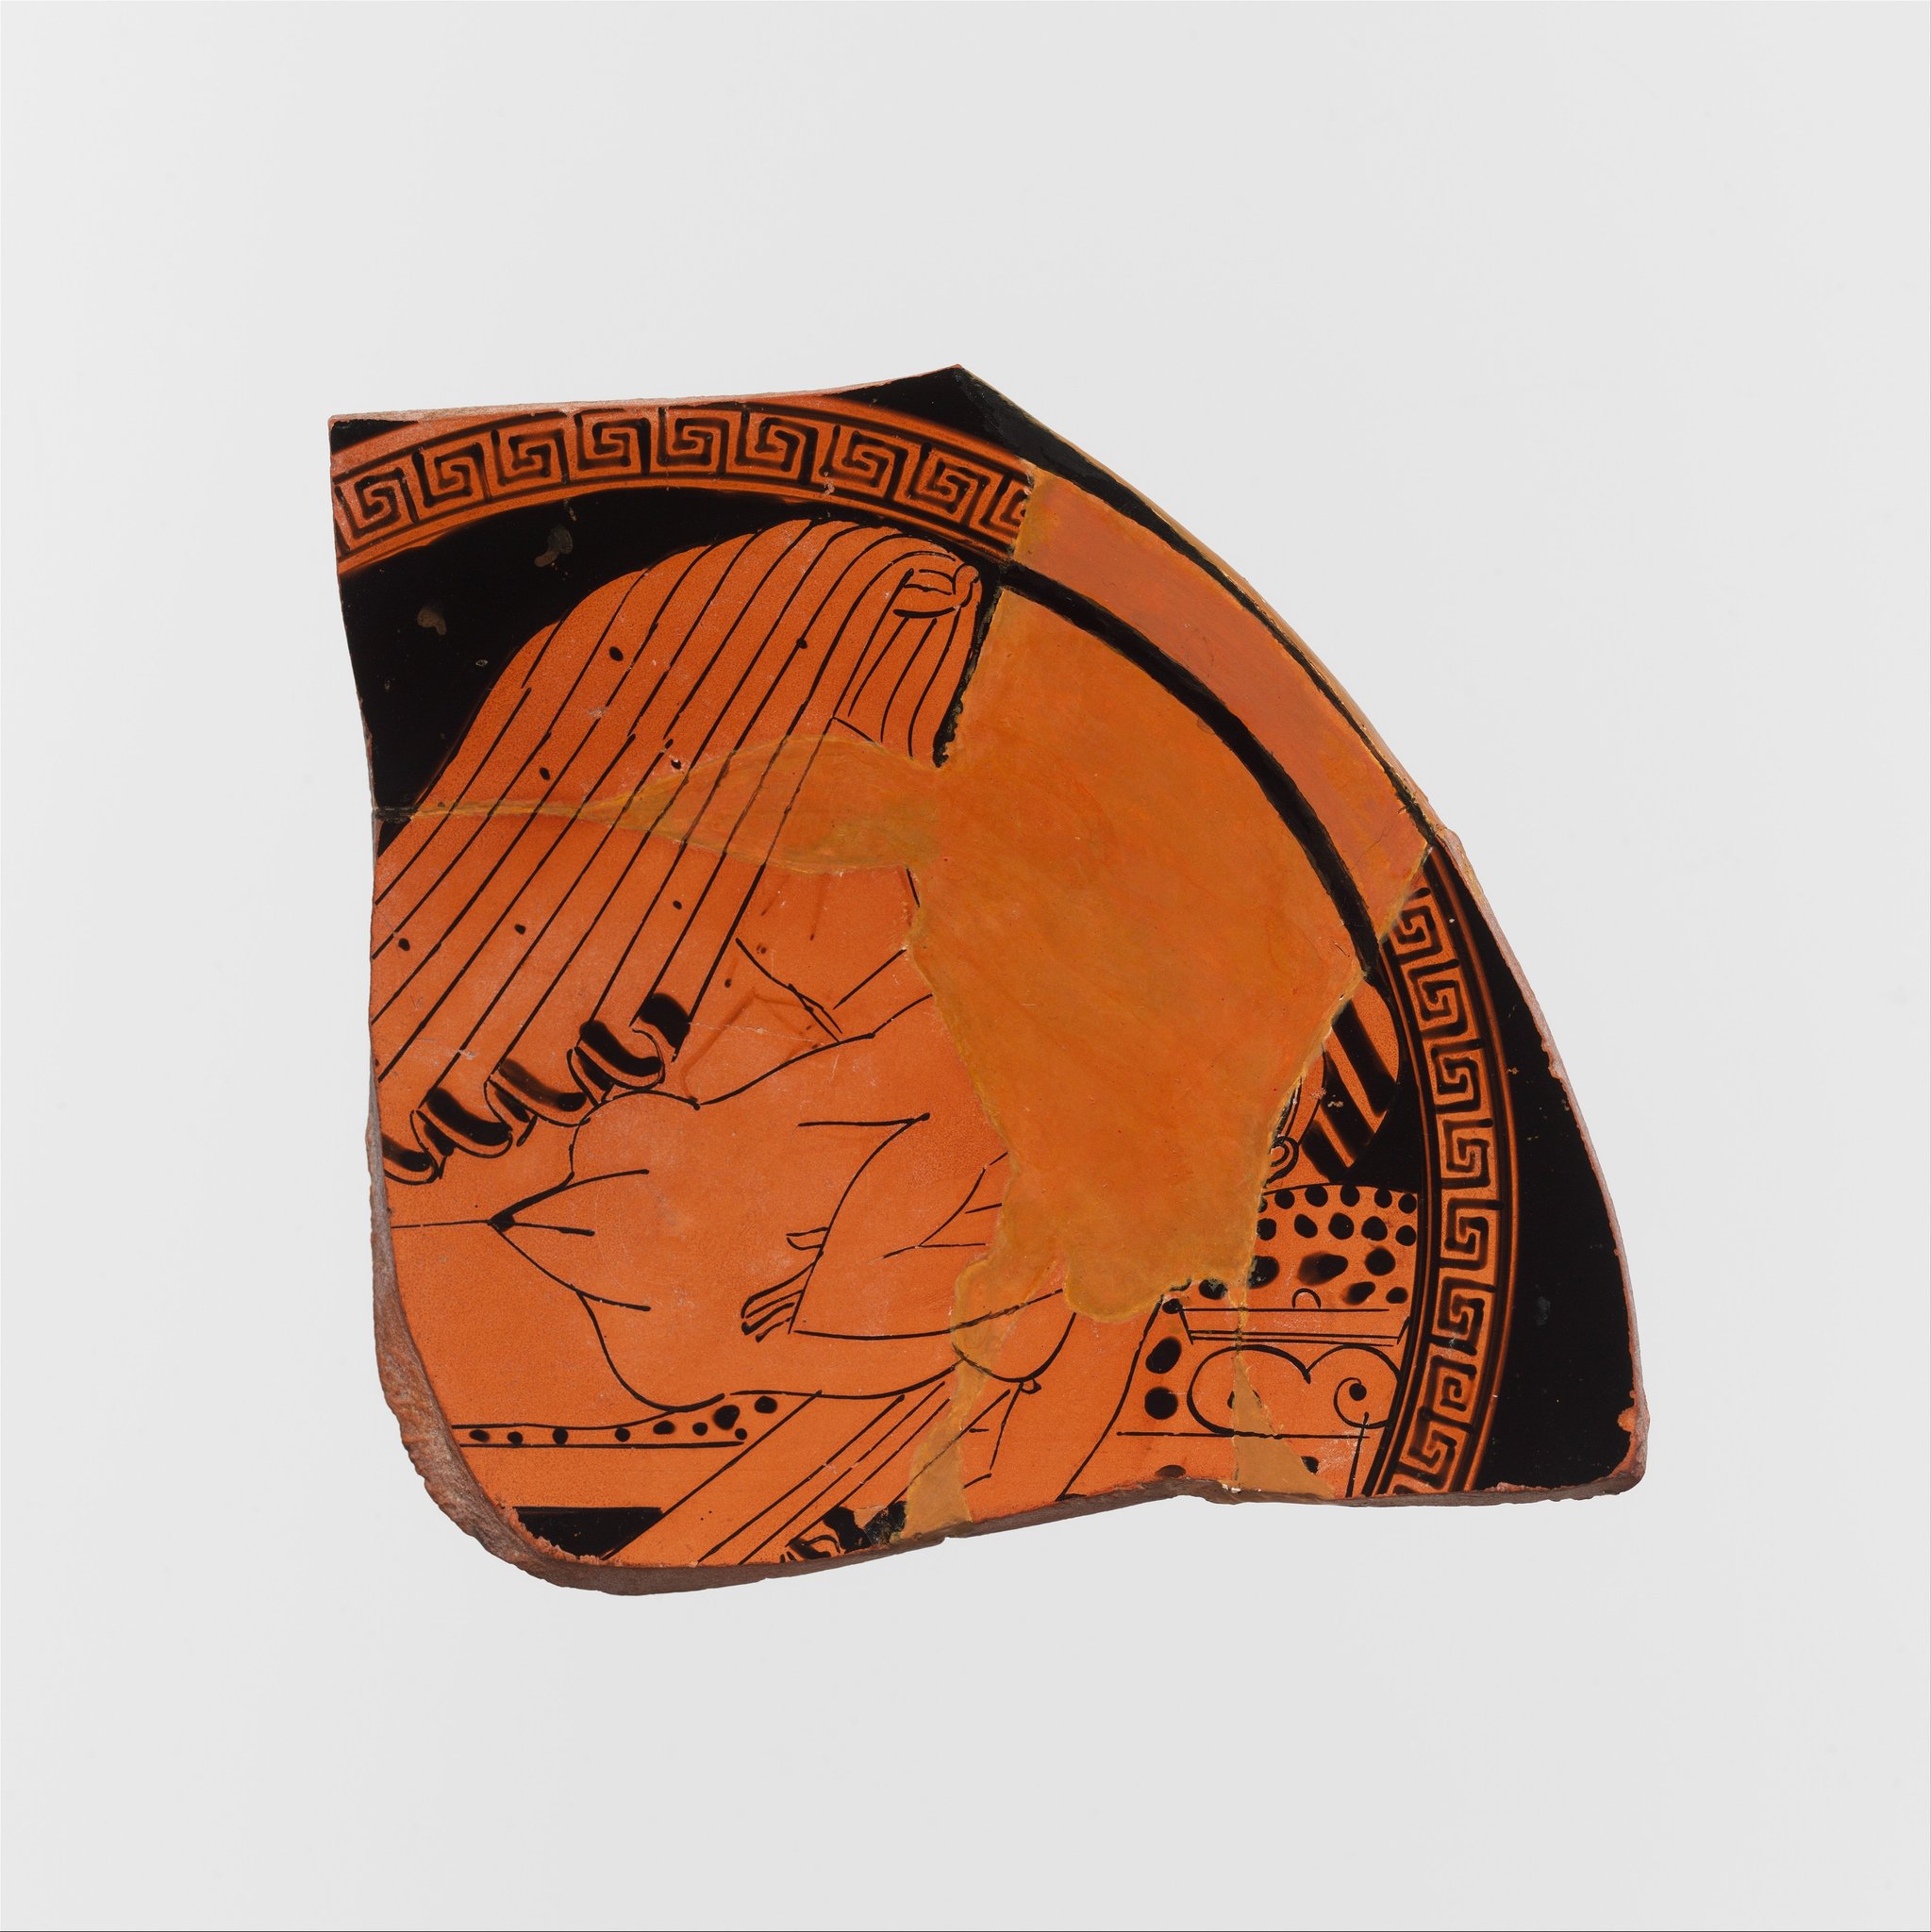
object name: kylix fragment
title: Fragment of a terracotta kylix (drinking cup)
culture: greek, attic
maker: eucharides painter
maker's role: artist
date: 490 BCE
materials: terracotta